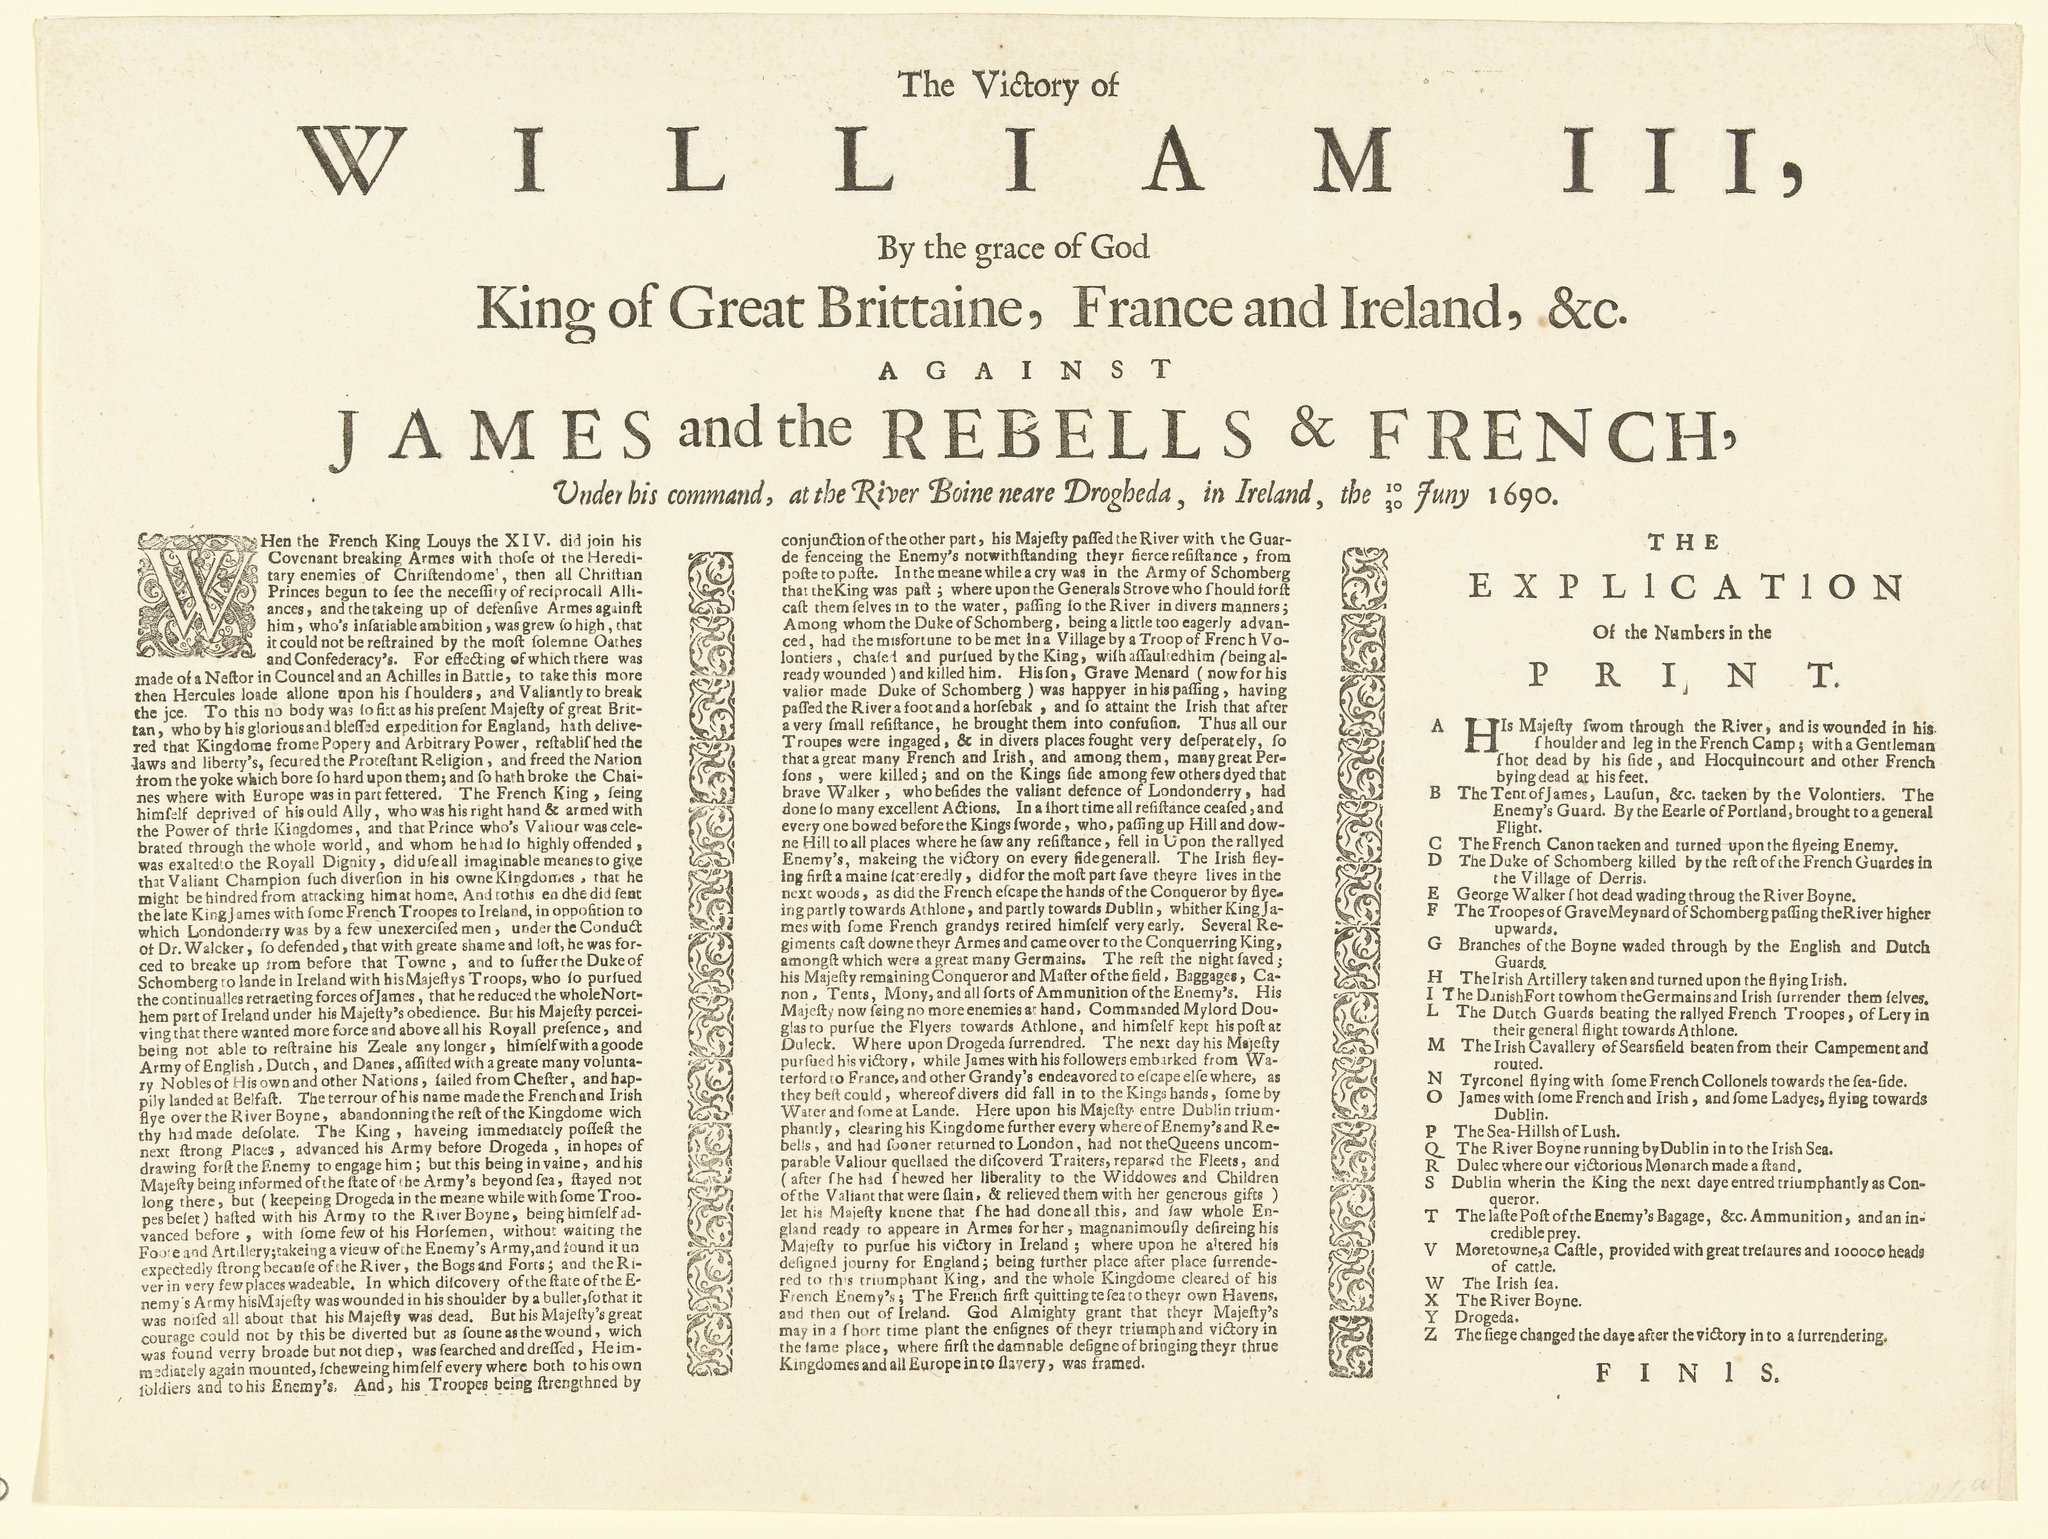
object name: propagandaprent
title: The victory of William III, By the grace of God King of Great Brittaine, France and Ireland, &c. against James and the Rebells & French, Under his command, at the River Boine neare Drogheda, in Ireland, the 10/30 Juny 1690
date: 1691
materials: paper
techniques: letterpress printing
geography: northern netherlands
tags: jacobus ii (koning van engeland en schotland), william iii (prince of orange and king of england, scotland, and ireland)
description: Overwinning van Willem III aan de Boyne, 1690. Geheel samengesteld uit drie losse prenten en twee tekstbladen. Tekstblad met een beschrijving van het verloop van de slag en de legenda A-Z, in 3 kolommen in het Engels.